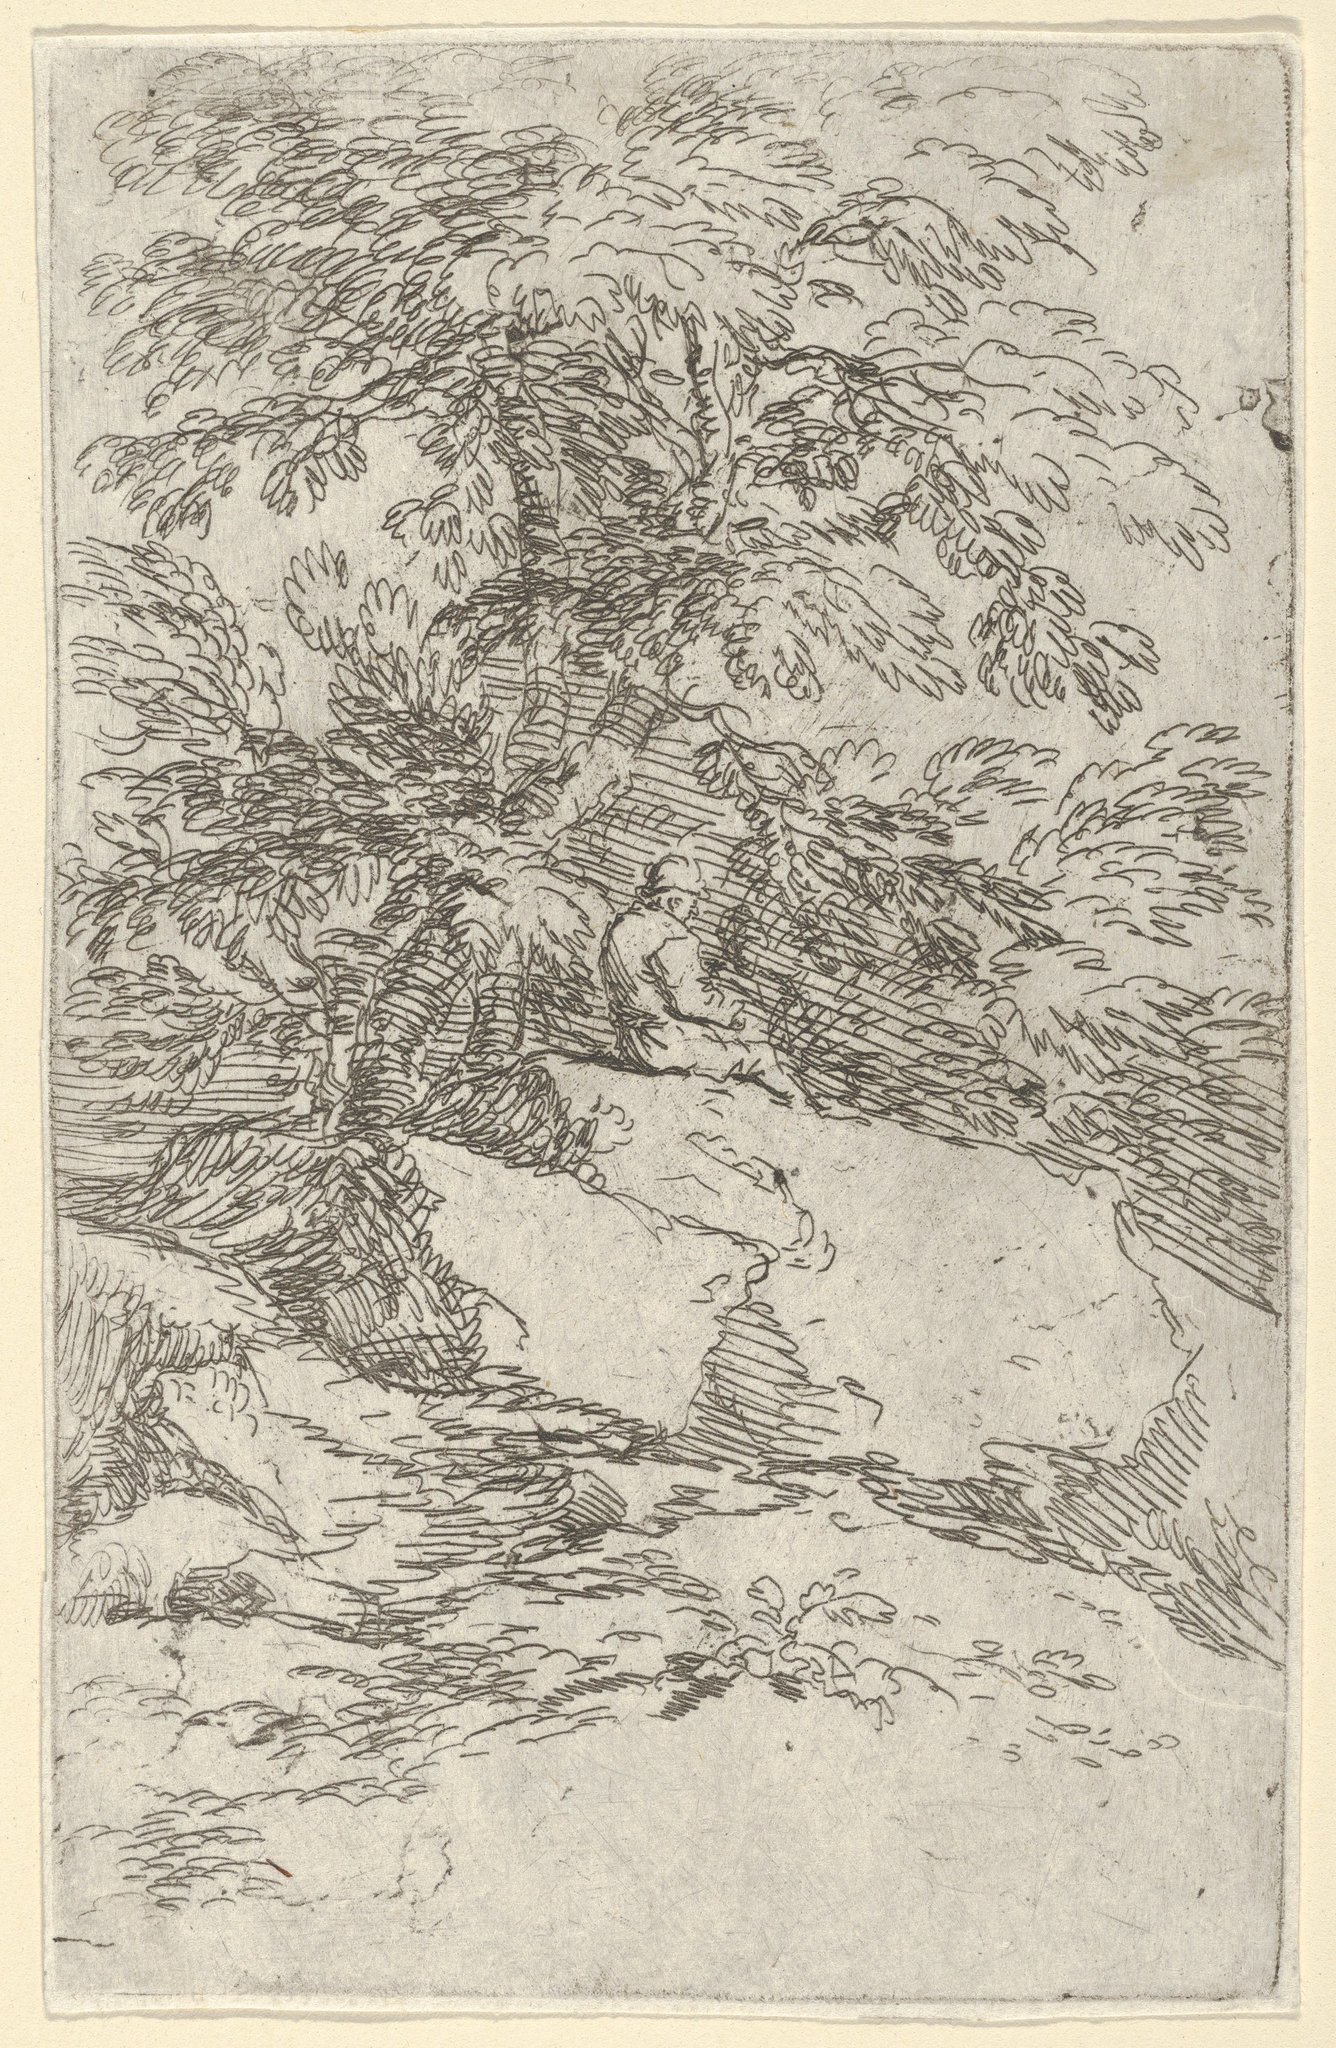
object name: print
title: Landscape with a figure seated on a rock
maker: salvator rosa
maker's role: artist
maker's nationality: italian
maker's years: 1615-1673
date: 1640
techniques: etching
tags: human figures,landscapes,trees